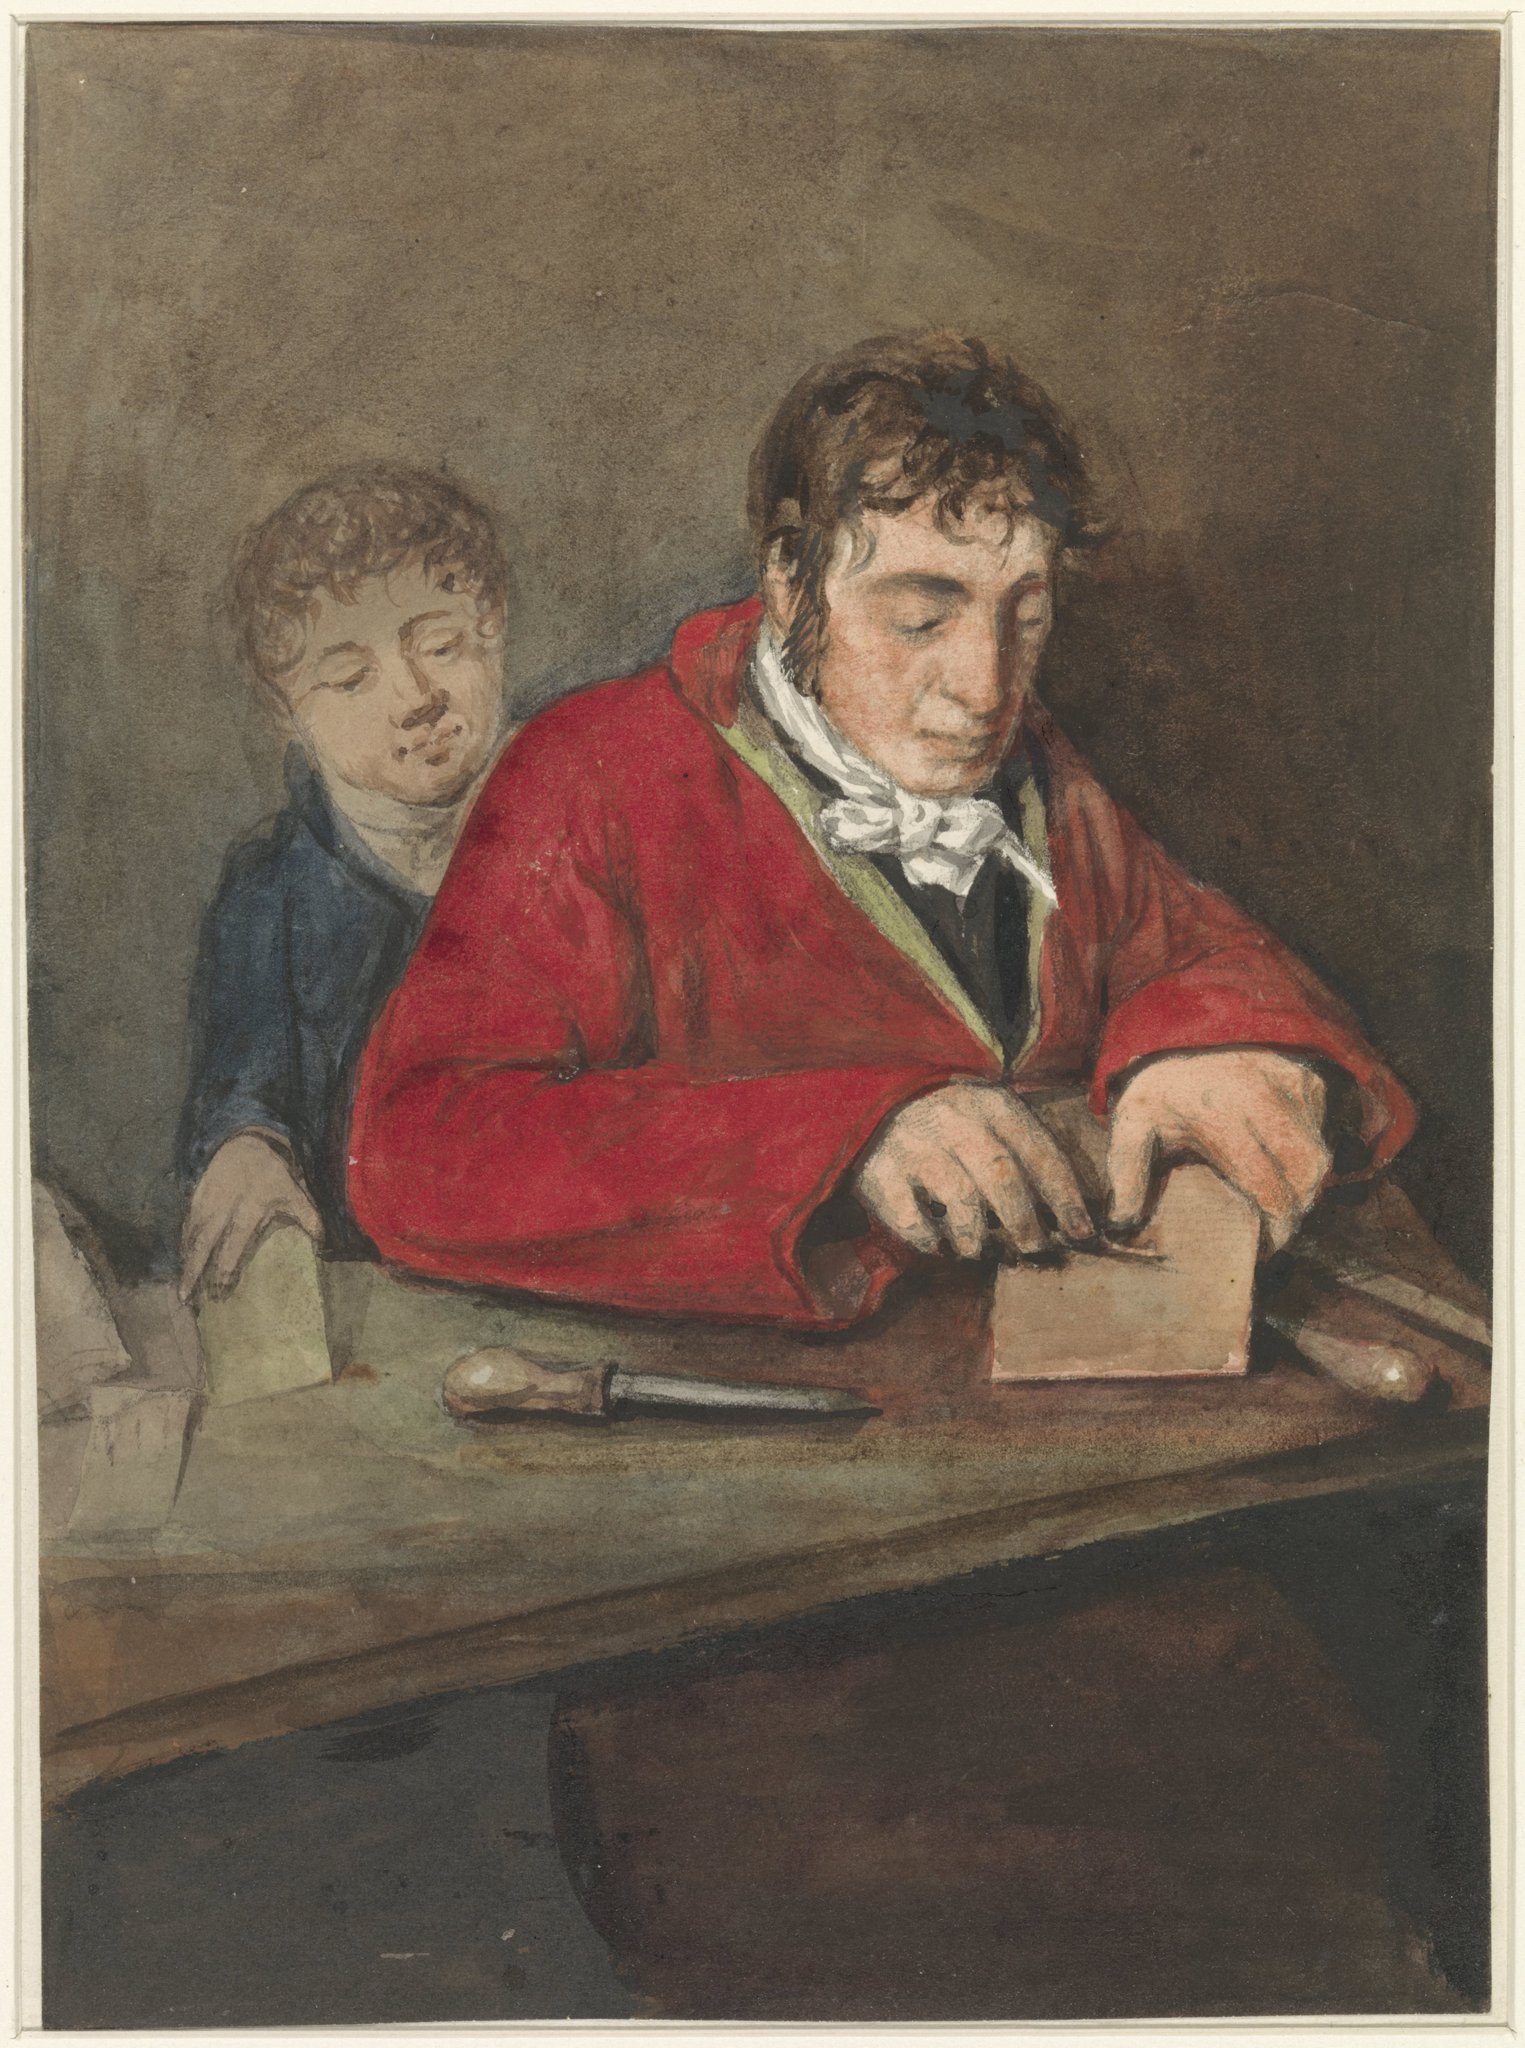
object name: drawing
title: Portret van Antonie van den Bosch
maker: gabriël van rooyen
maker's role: draughtsman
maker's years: 1752-1817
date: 1802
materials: chalk, paper, pencil, watercolor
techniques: brush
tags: nijmegen, amsterdam, print maker, draughtsman, anthonie van den bos, engraver, etcher, historical persons, portrait, self-portrait of painter, portrait, self-portrait of artist, portrait, self-portrait of draughtsman